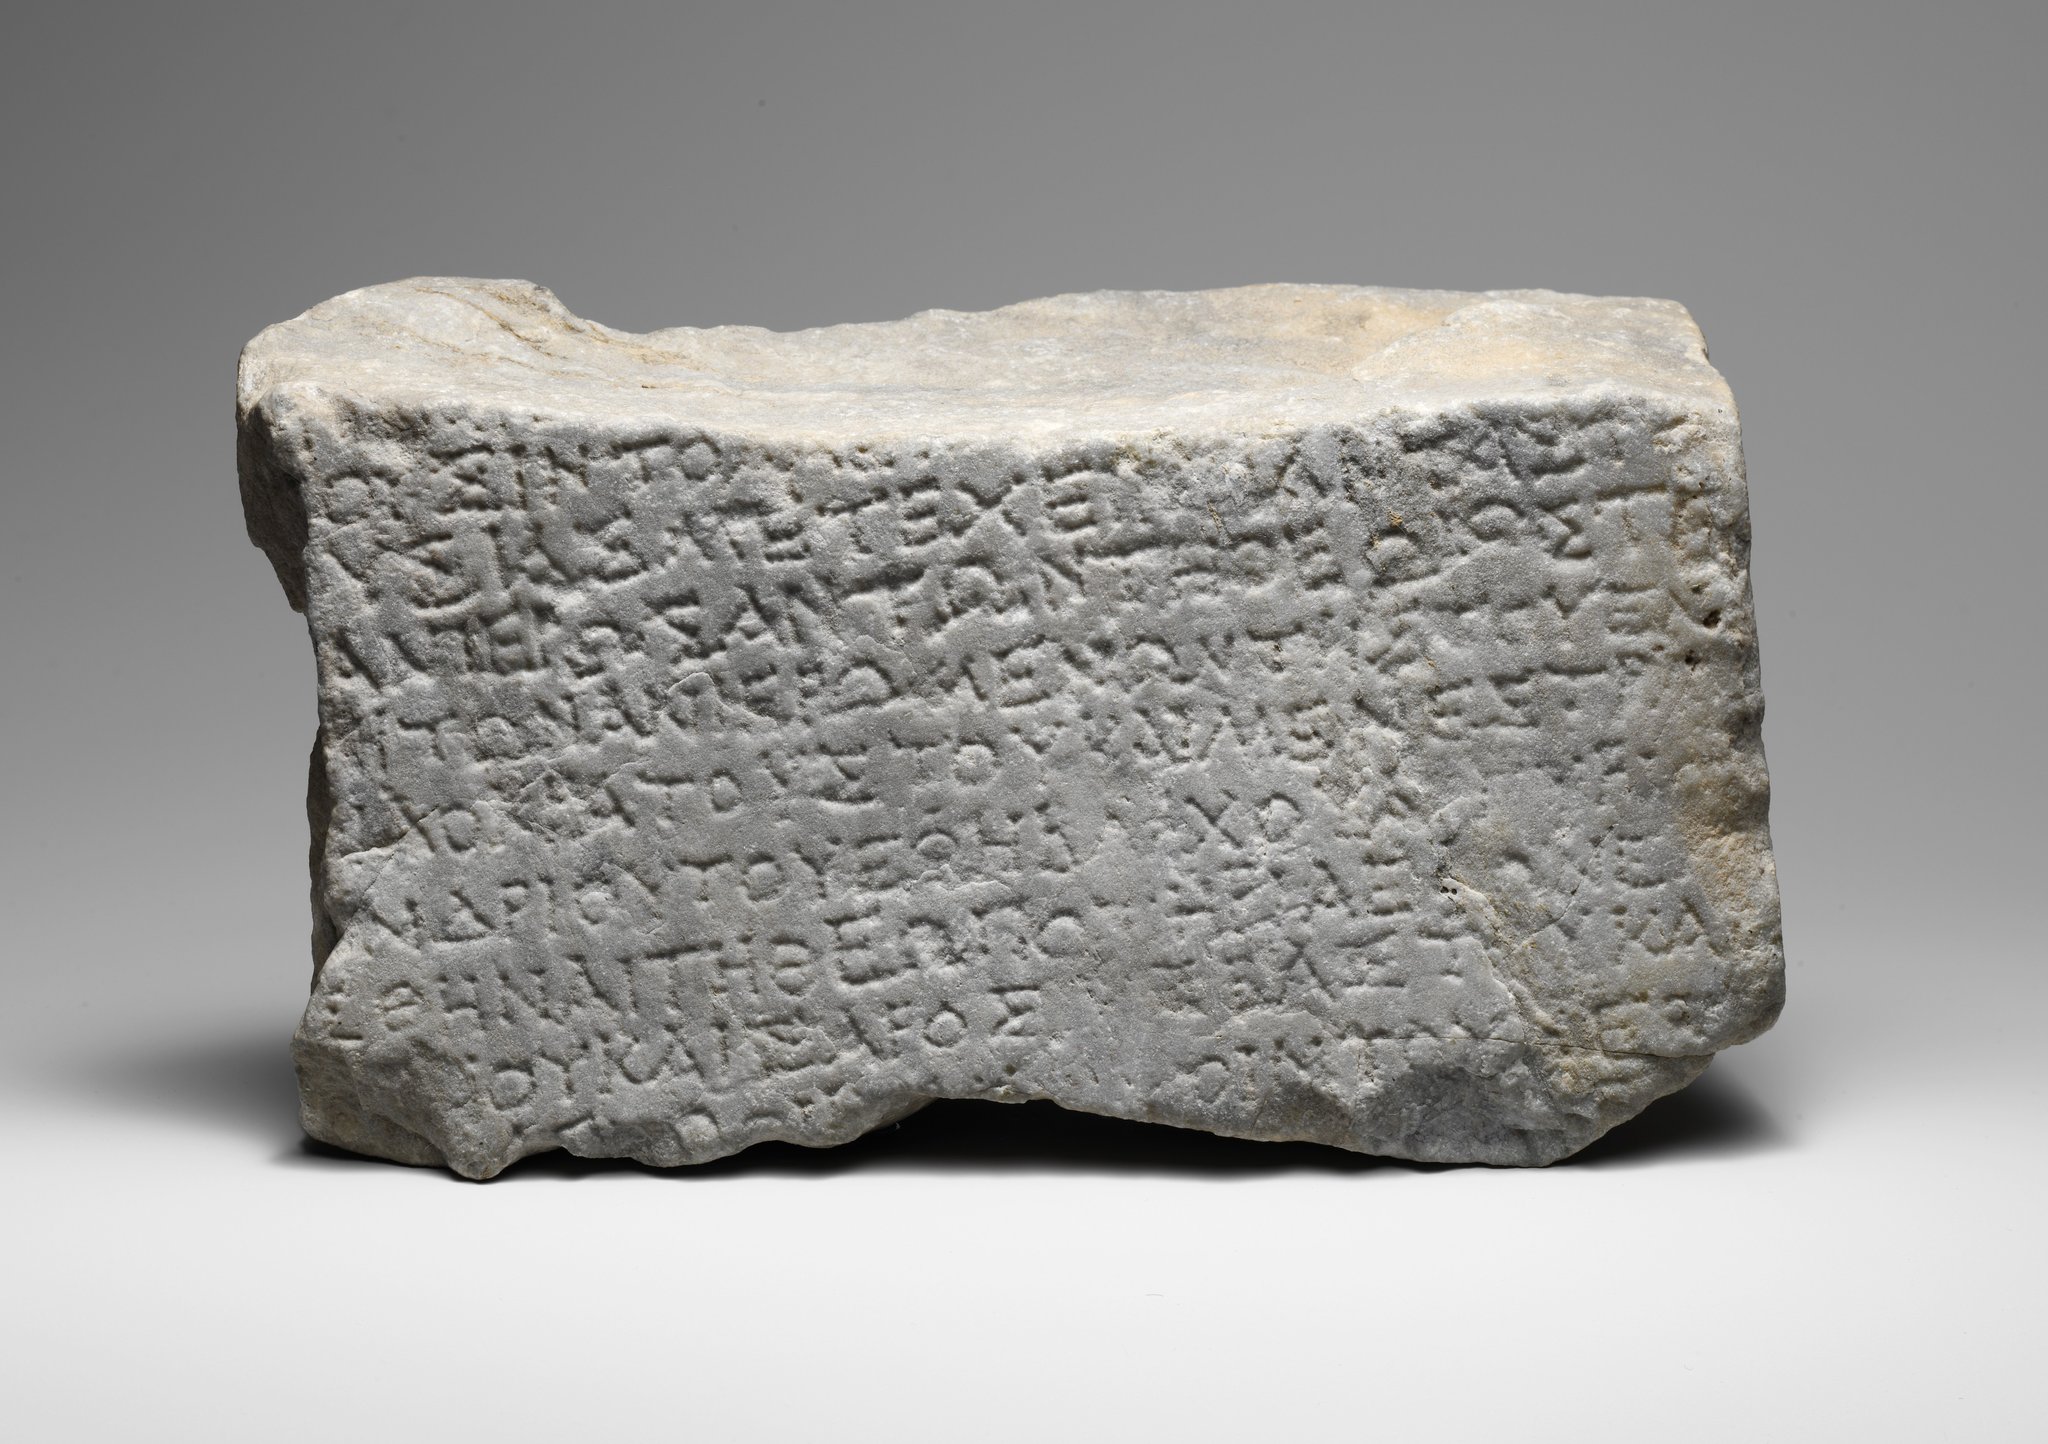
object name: inscription, fragment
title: Marble inscribed block fragment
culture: roman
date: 1-50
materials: marble